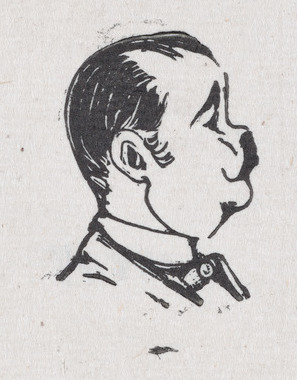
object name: print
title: A profile of a man looking to the right with a dark mustache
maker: josé guadalupe posada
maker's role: artist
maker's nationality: mexican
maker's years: 1852-1913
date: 1880-1910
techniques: woodcut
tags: men,profiles